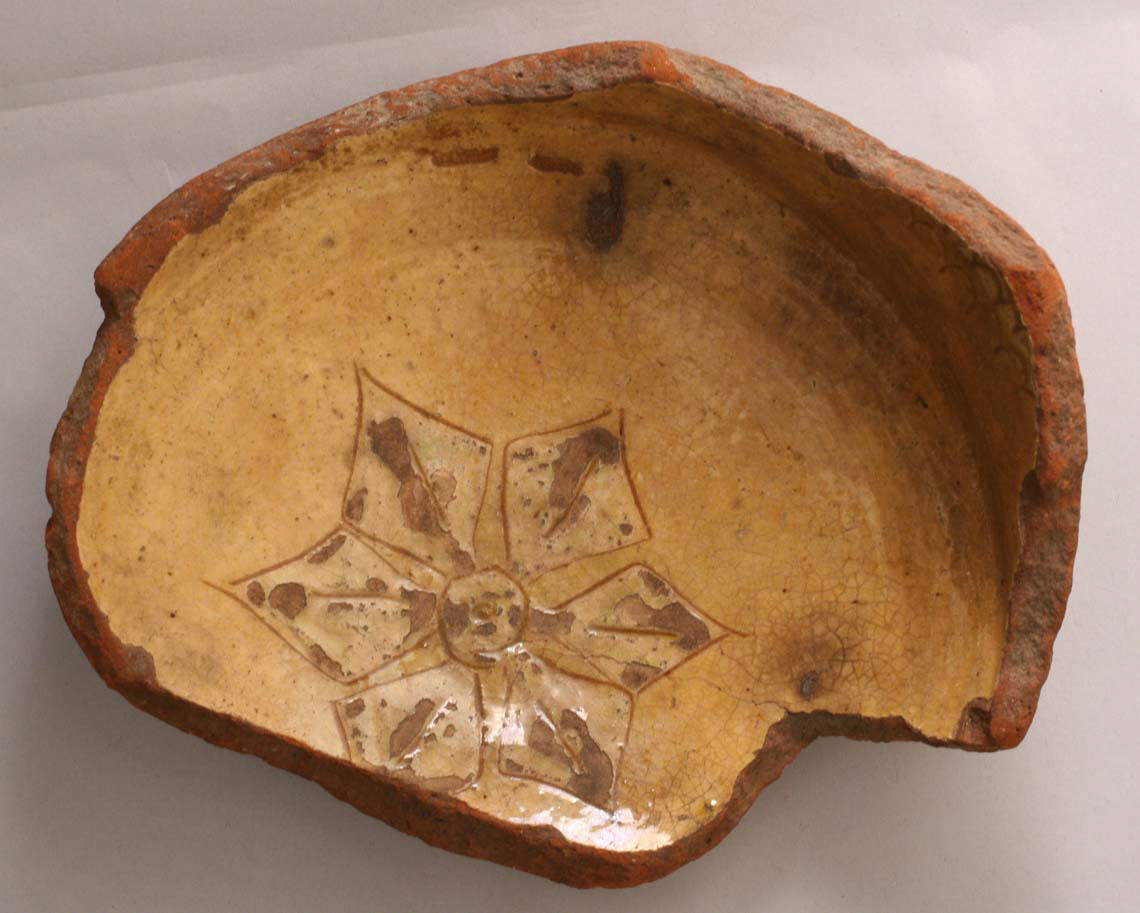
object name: ceramic fragment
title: Fragment of a Bowl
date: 1301-1500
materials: earthenware, glaze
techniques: coloring, incising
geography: egypt